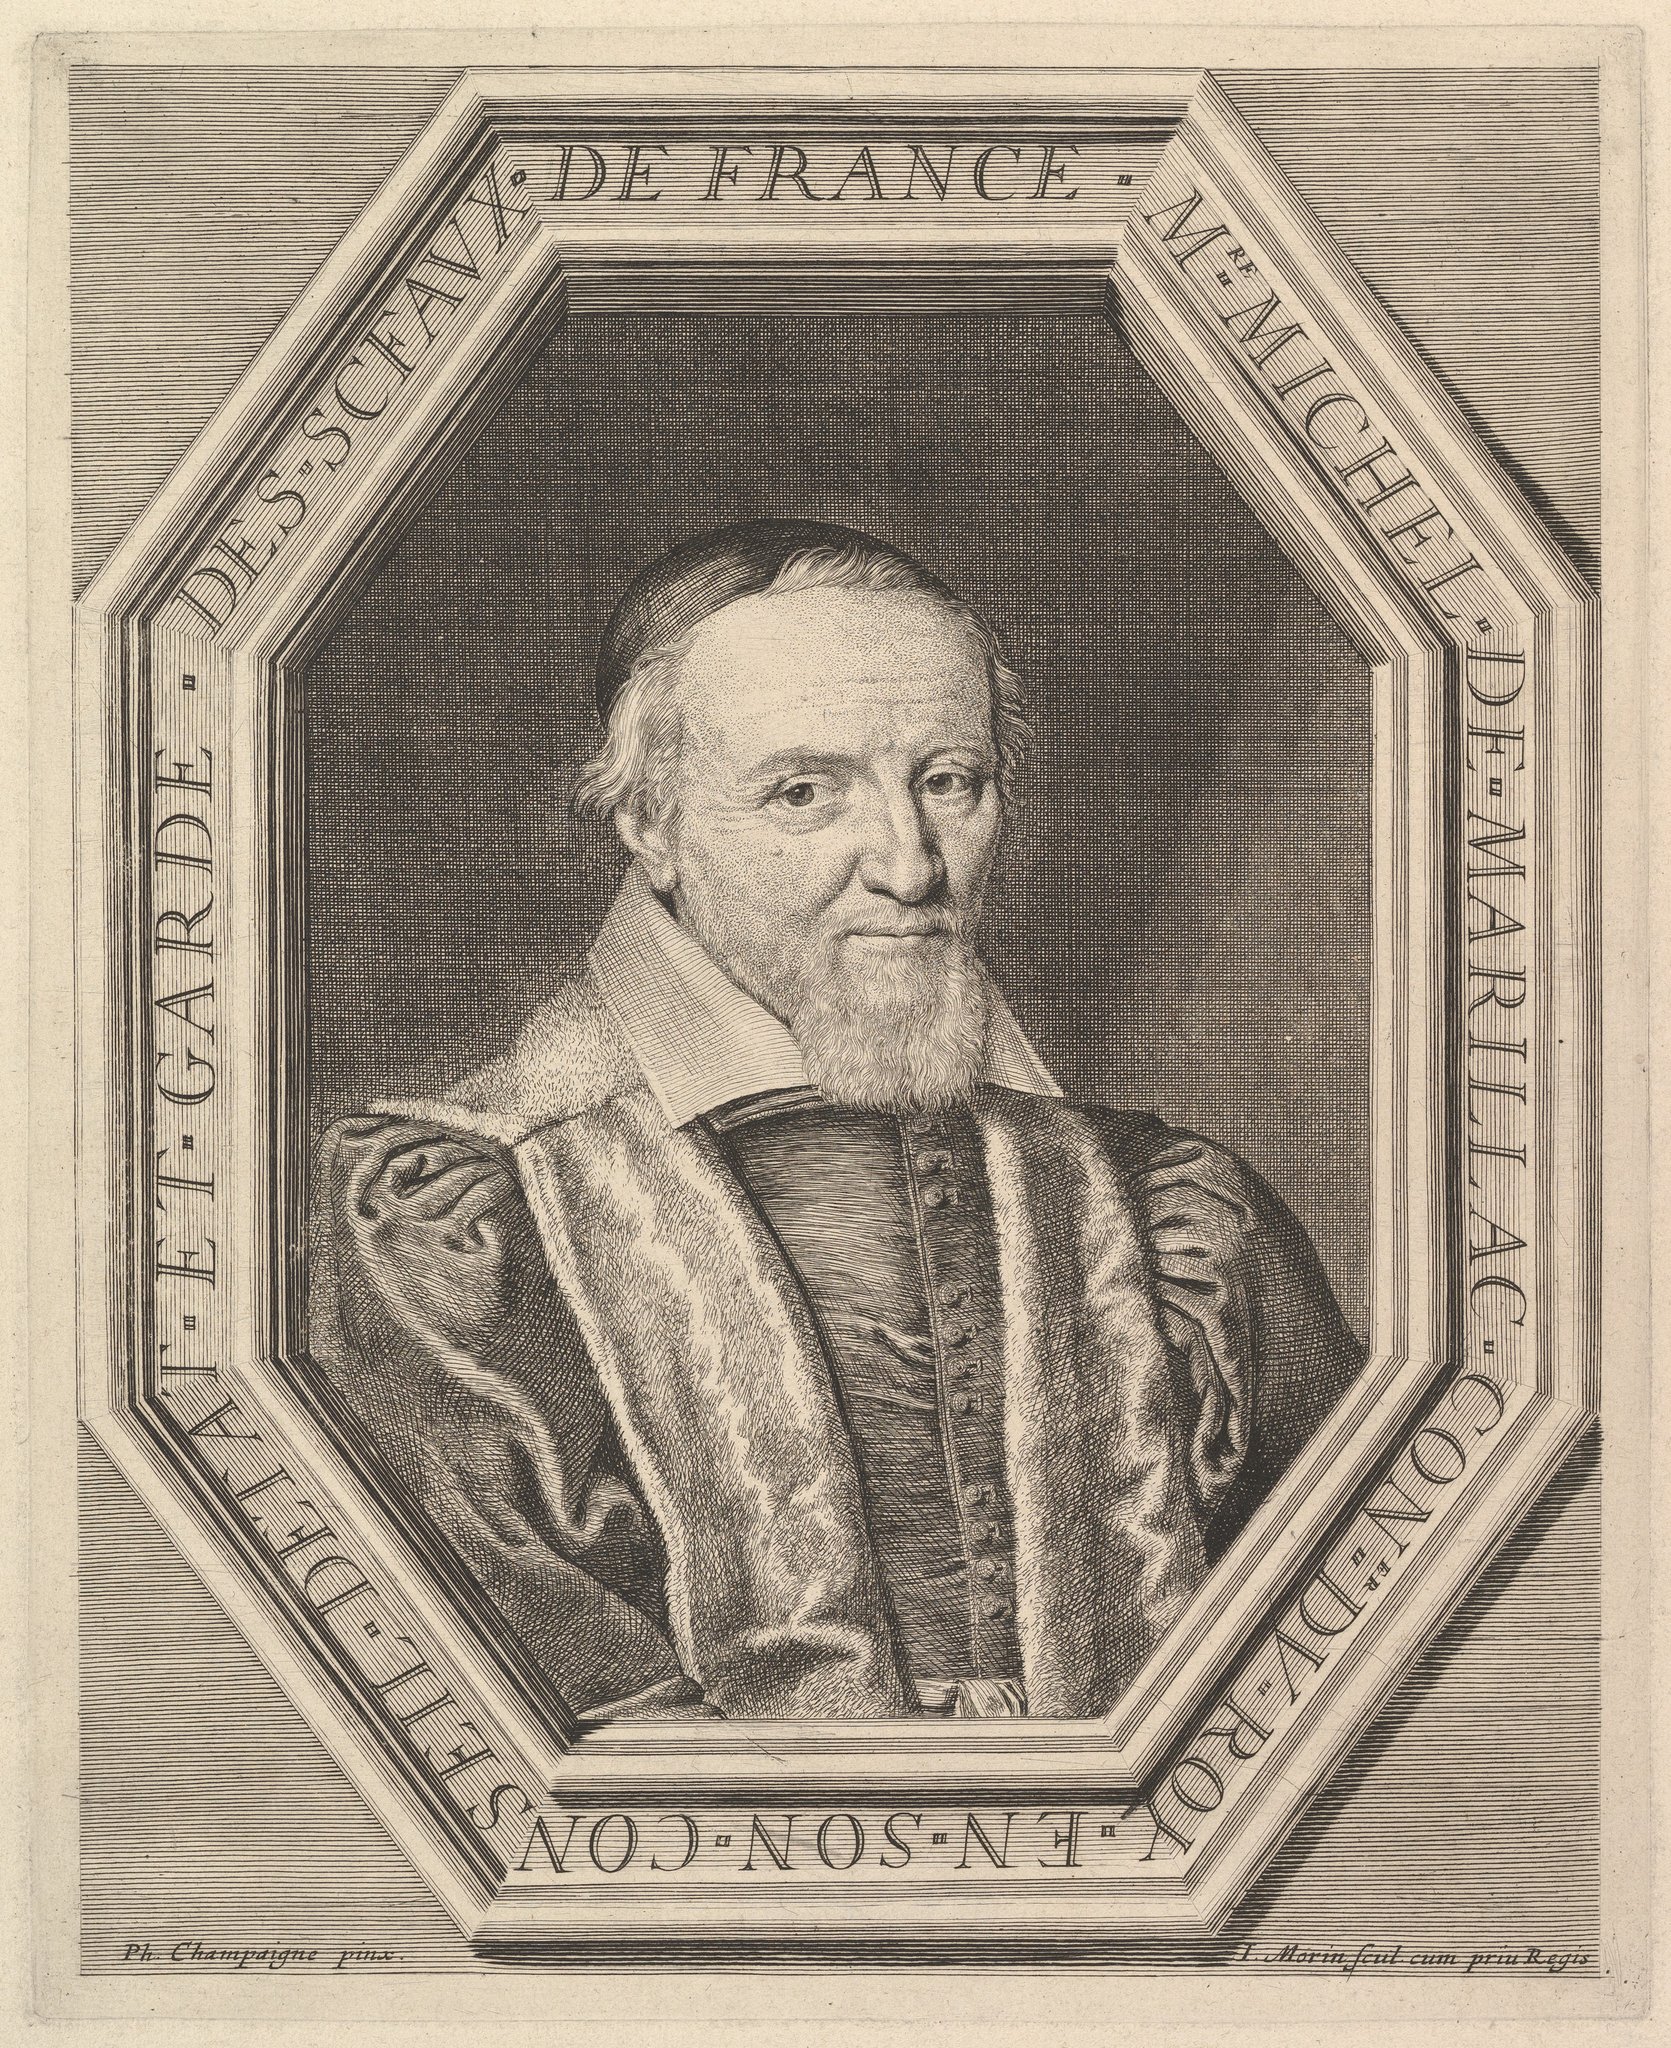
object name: print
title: Michel de Marillac, conseiller d'etat et garde des sceaux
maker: jean morin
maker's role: artist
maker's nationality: french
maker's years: 1605-1650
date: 1605-1650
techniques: etching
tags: men,portraits